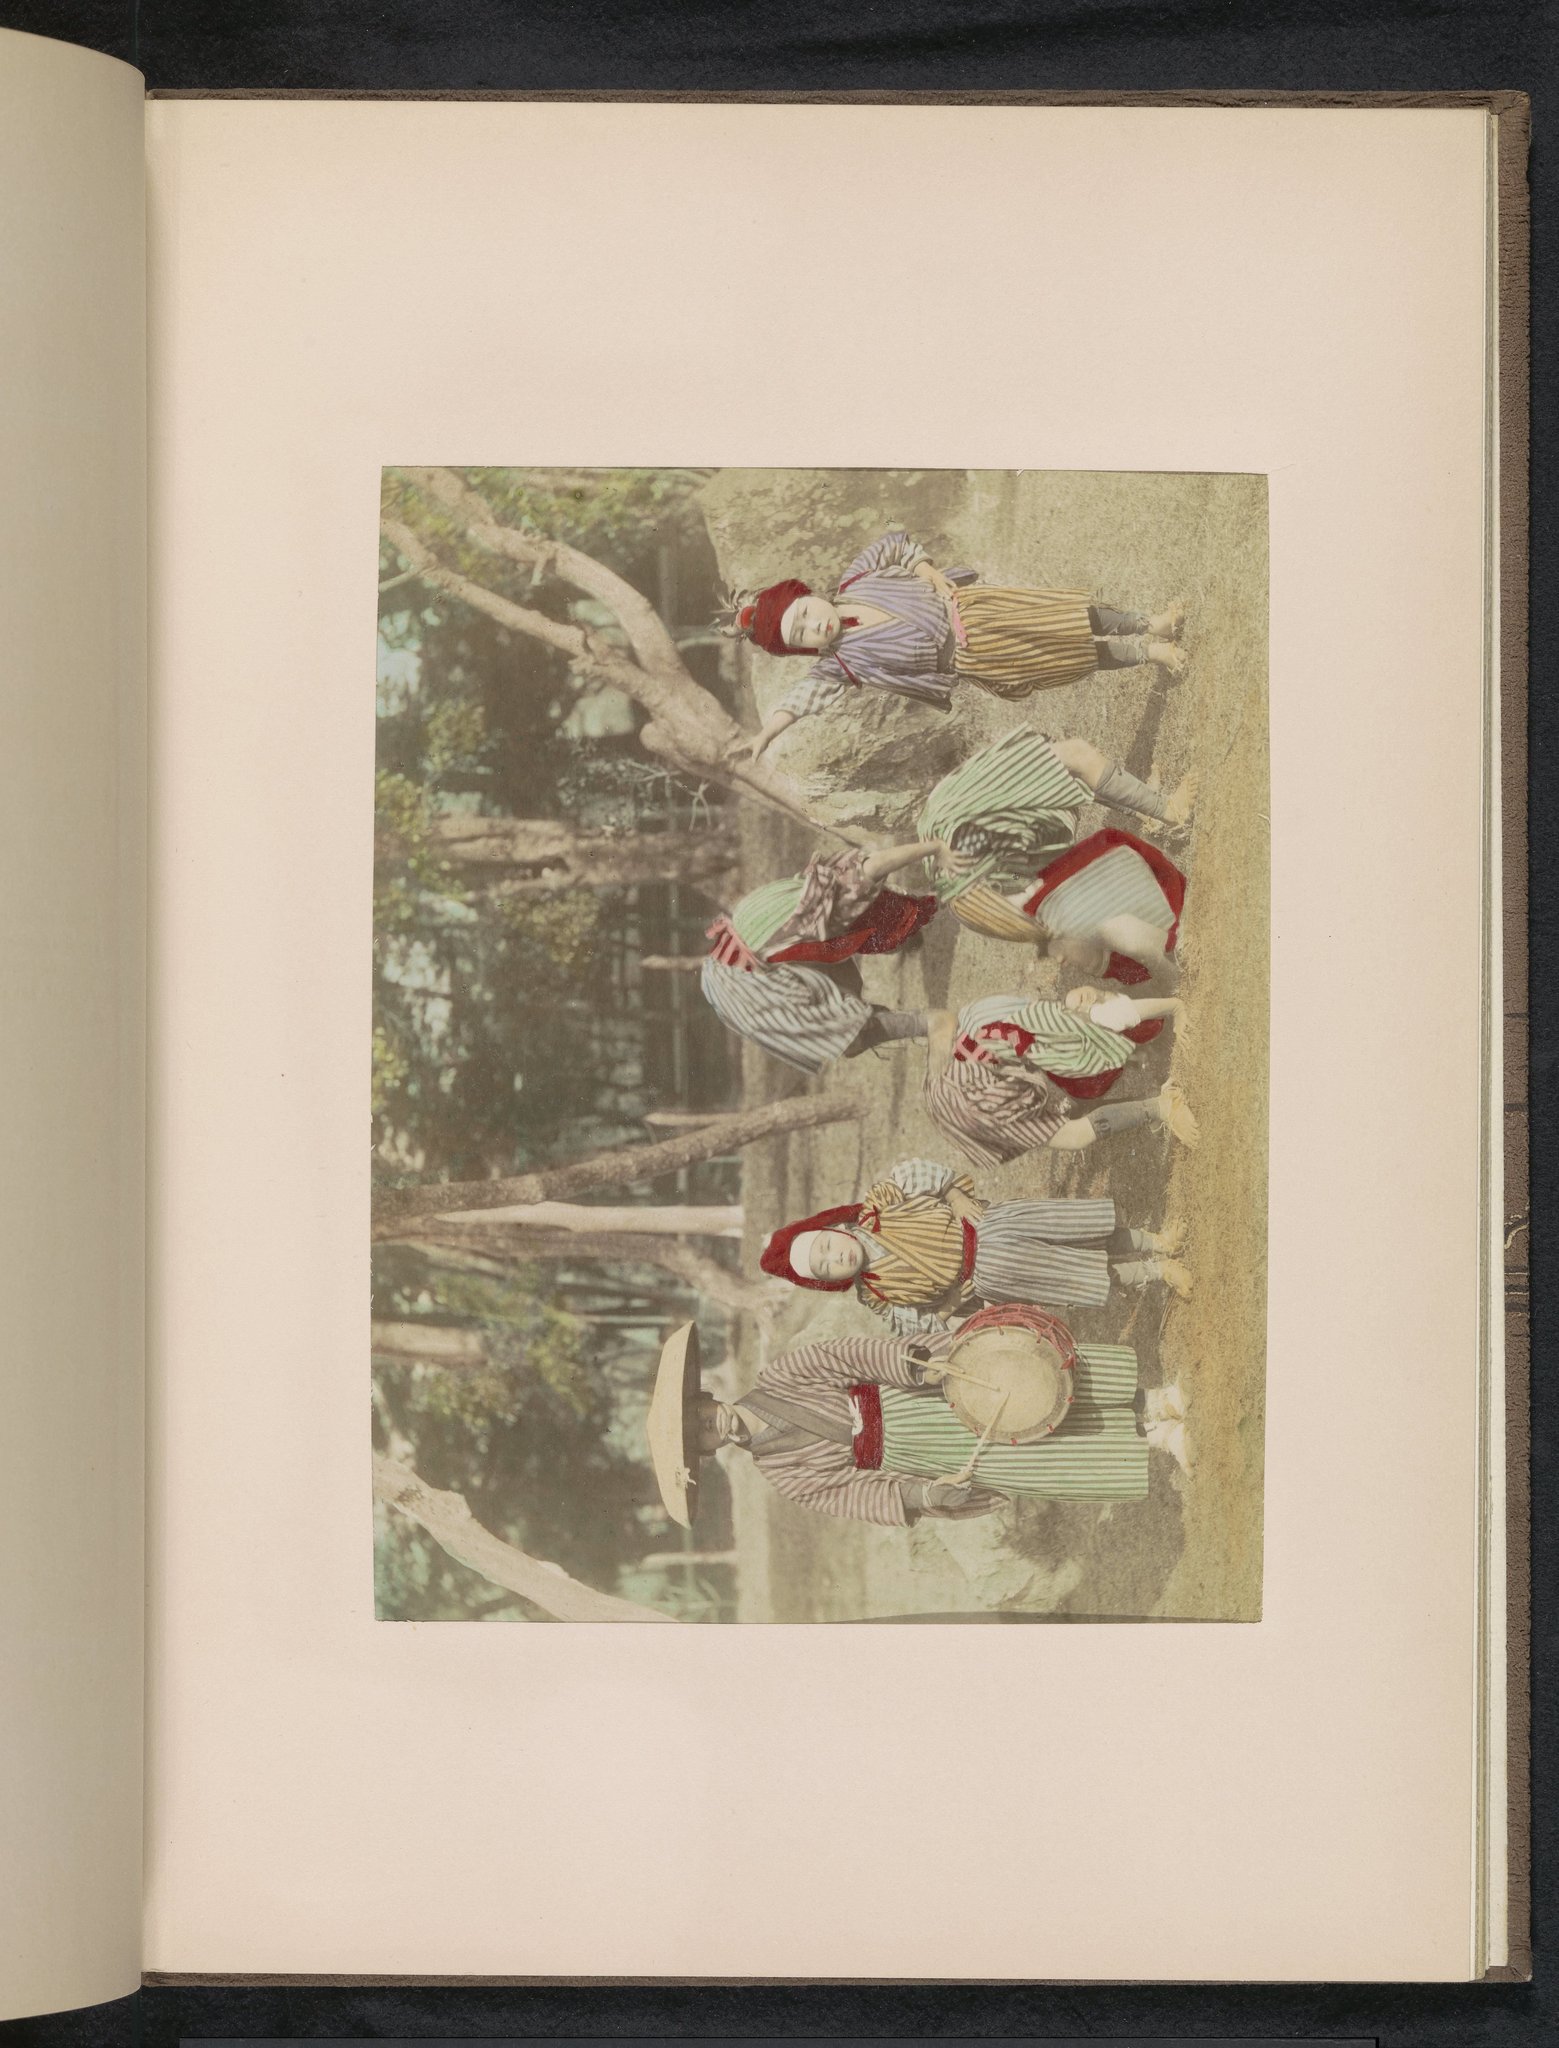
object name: photograph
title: Kind-acrobaten en hun begeleider in een park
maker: Anonymous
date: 1887-1897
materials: photographic support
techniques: albumen print, hand coloring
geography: japan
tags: park, acrobat ~ circus, drum (musical instrument)